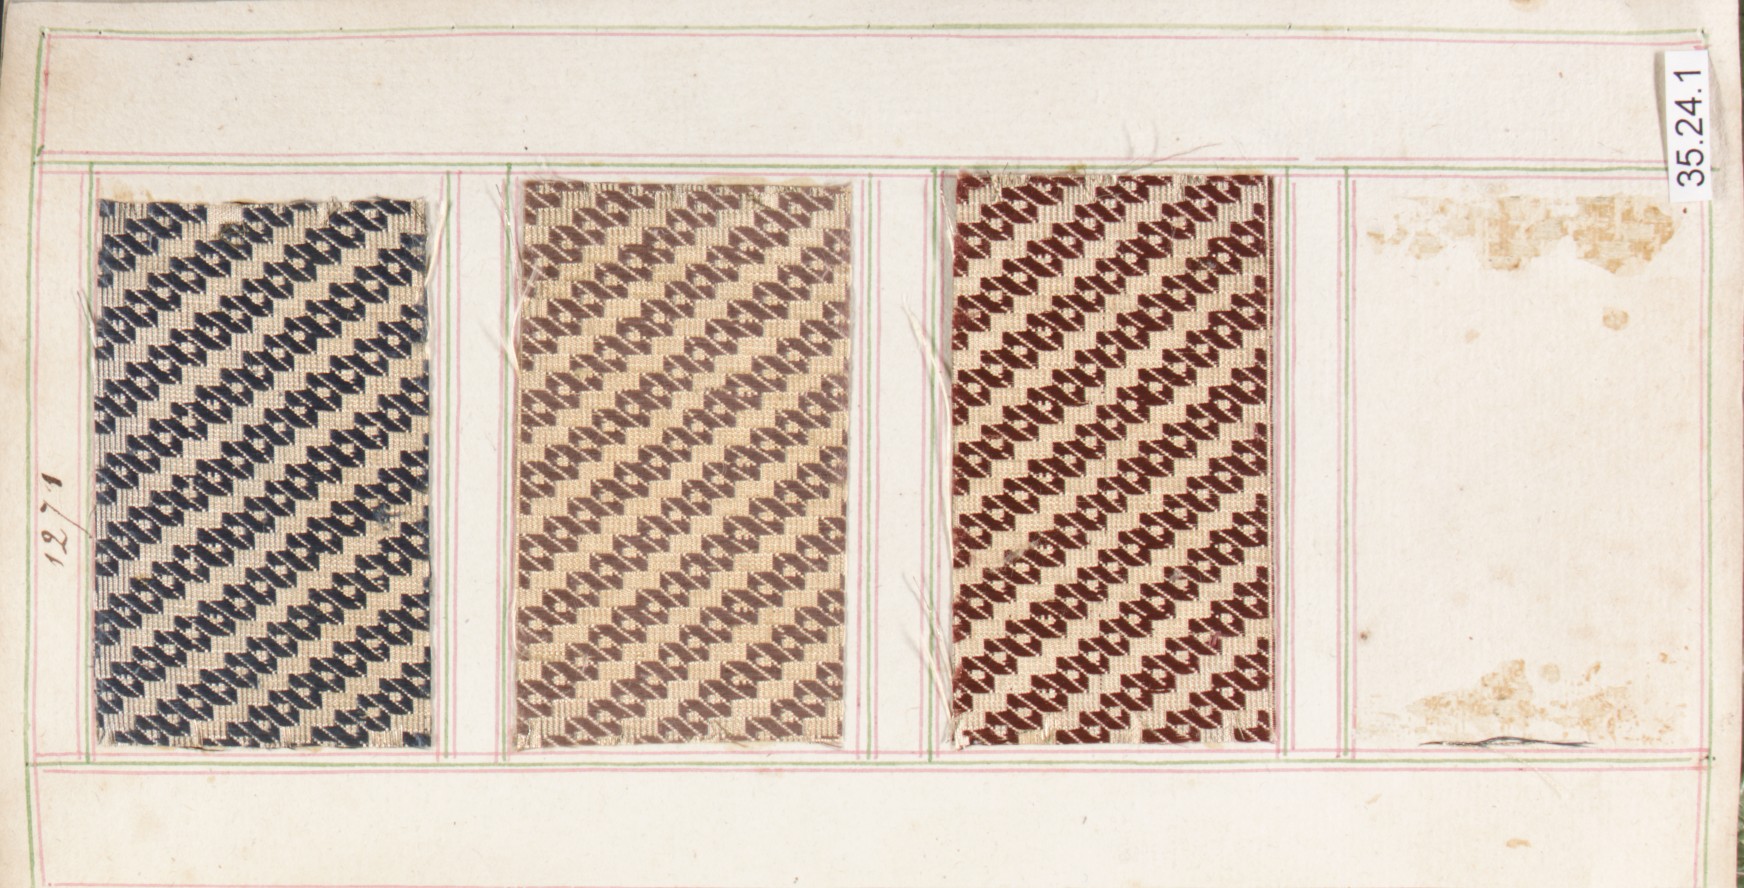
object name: sample book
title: Textile Sample Book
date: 1701-1800